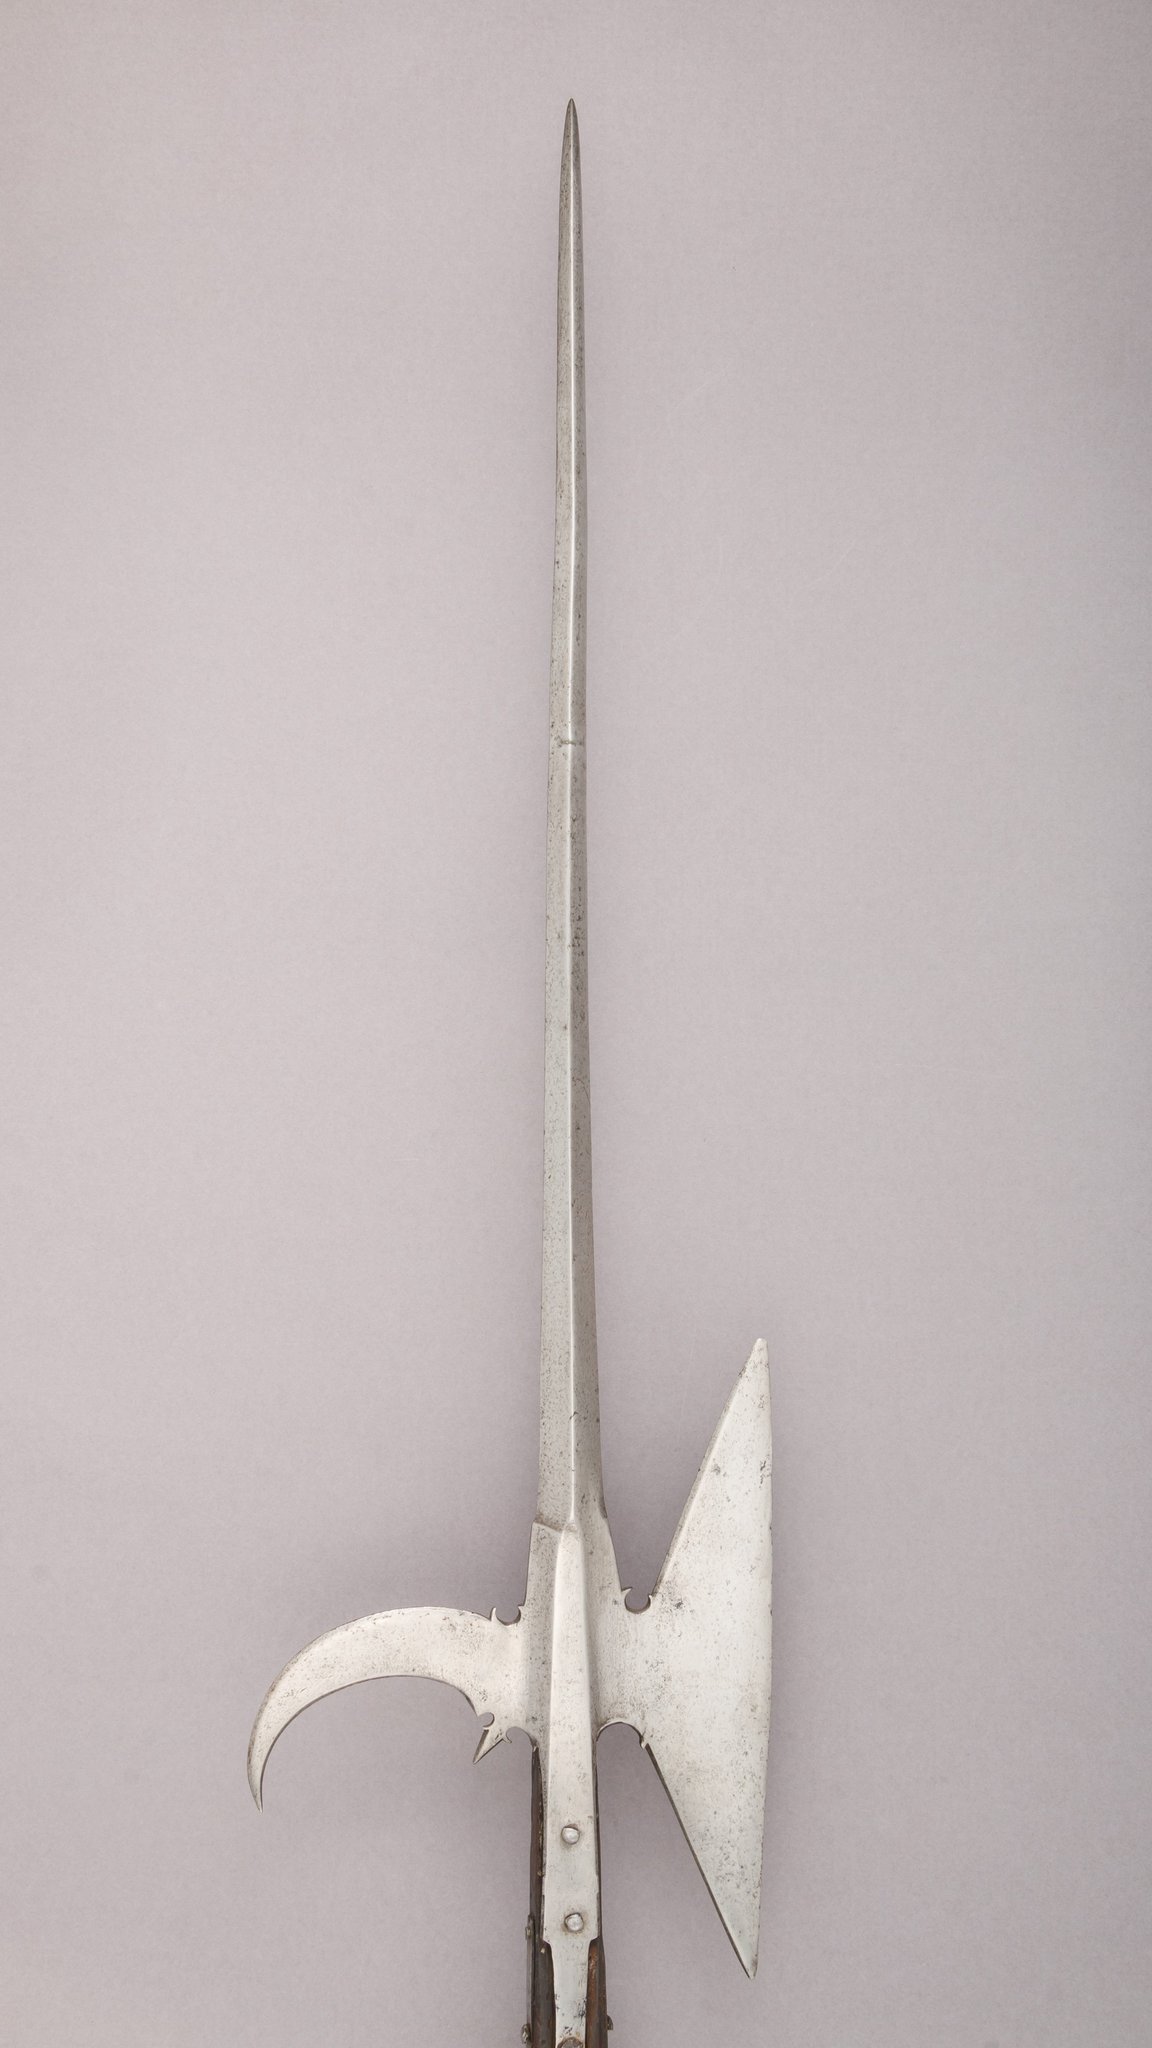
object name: halberd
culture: german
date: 1501-1600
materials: steel, wood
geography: germany